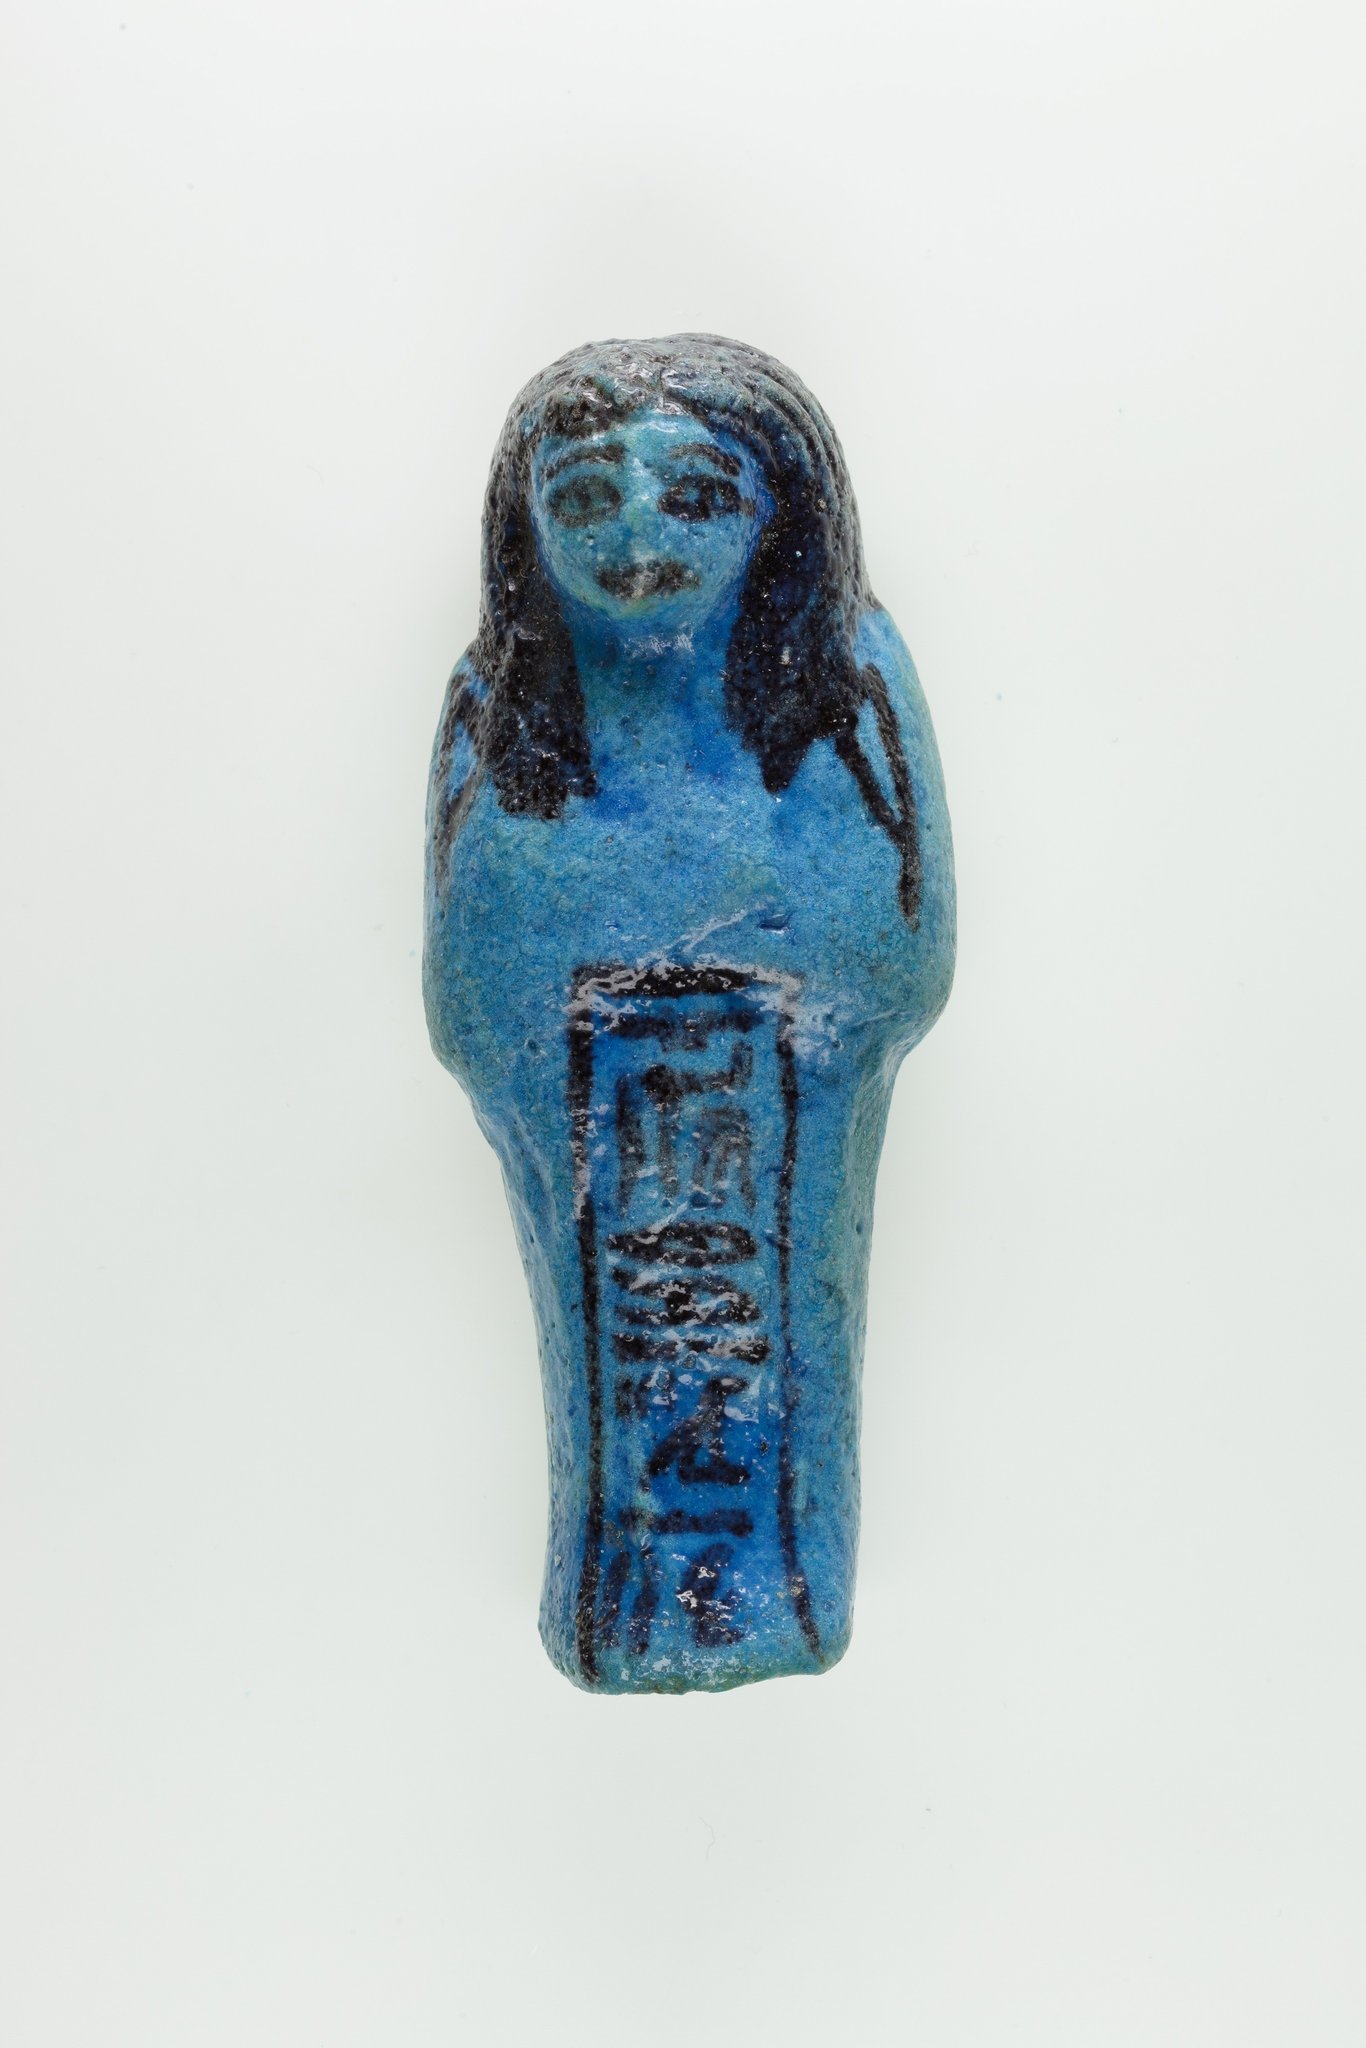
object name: shabti, worker, nauny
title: Worker Shabti of Nauny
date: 1050 BCE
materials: faience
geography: egypt